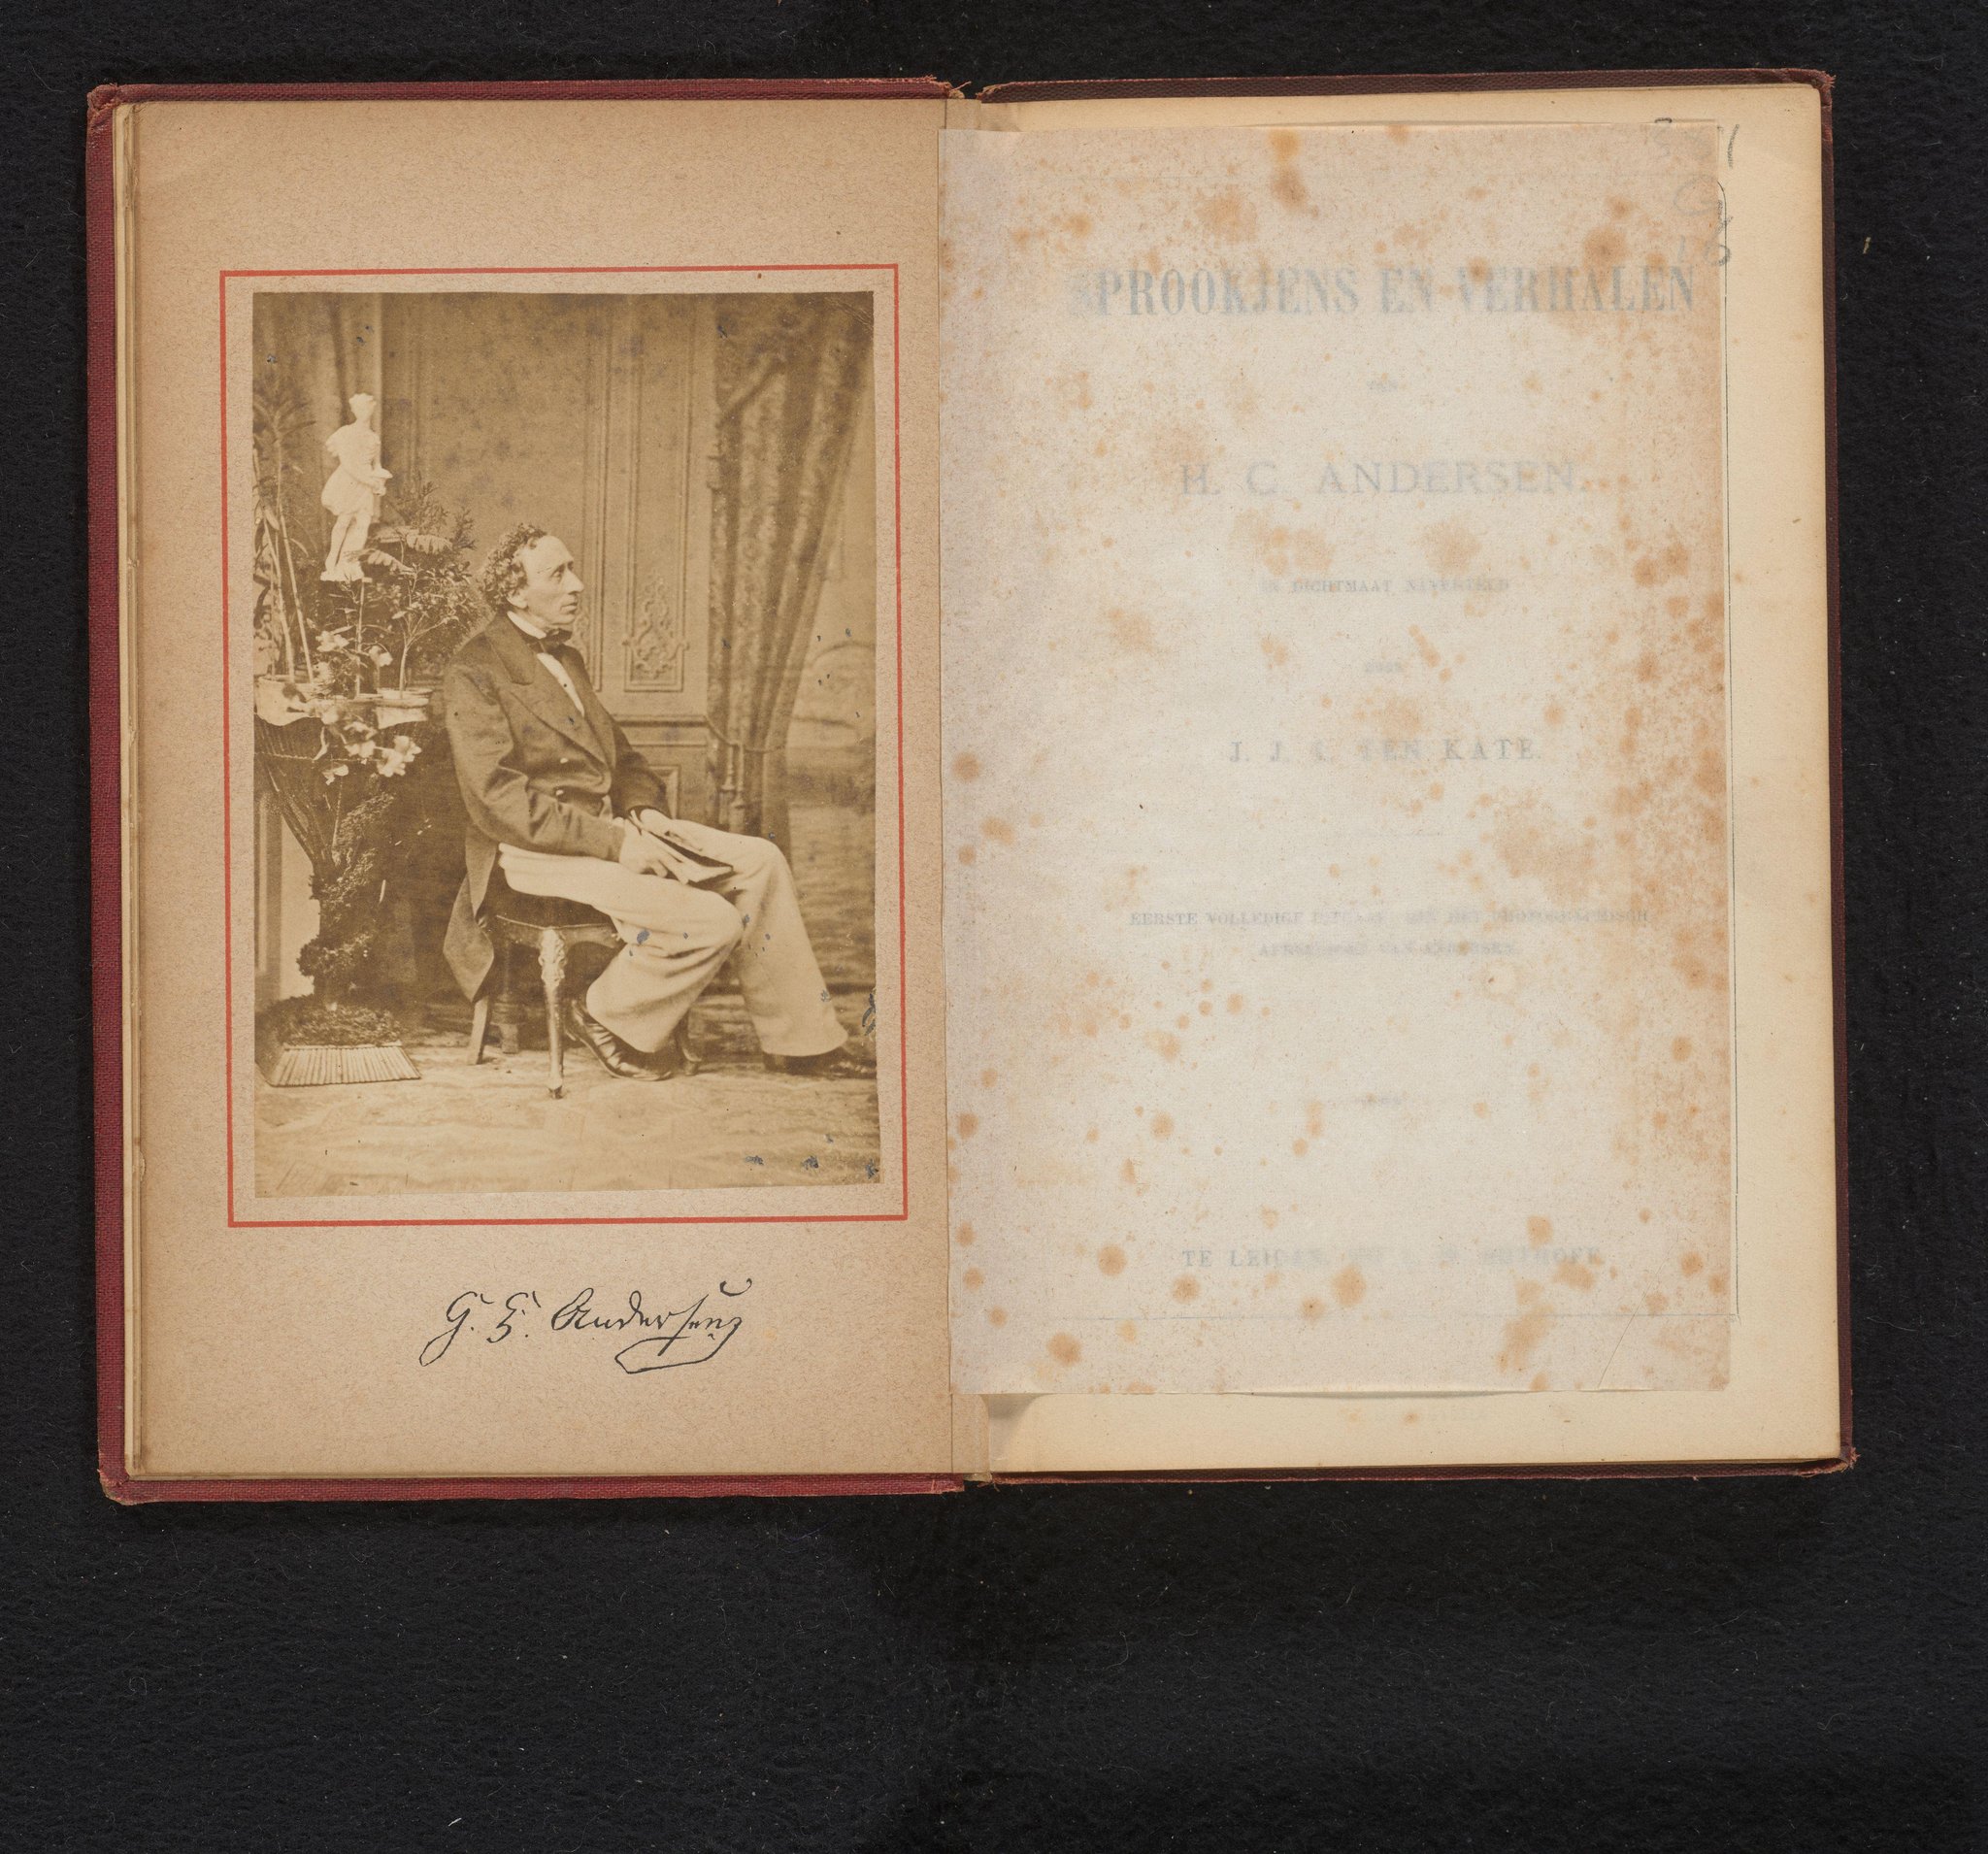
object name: page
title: Portret van Hans Christian Andersen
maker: Anonymous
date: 1863-1868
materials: paper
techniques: albumen print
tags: hans christian andersen, historical persons, portrait of a writer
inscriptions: signature: ‘H.C. Andersen’